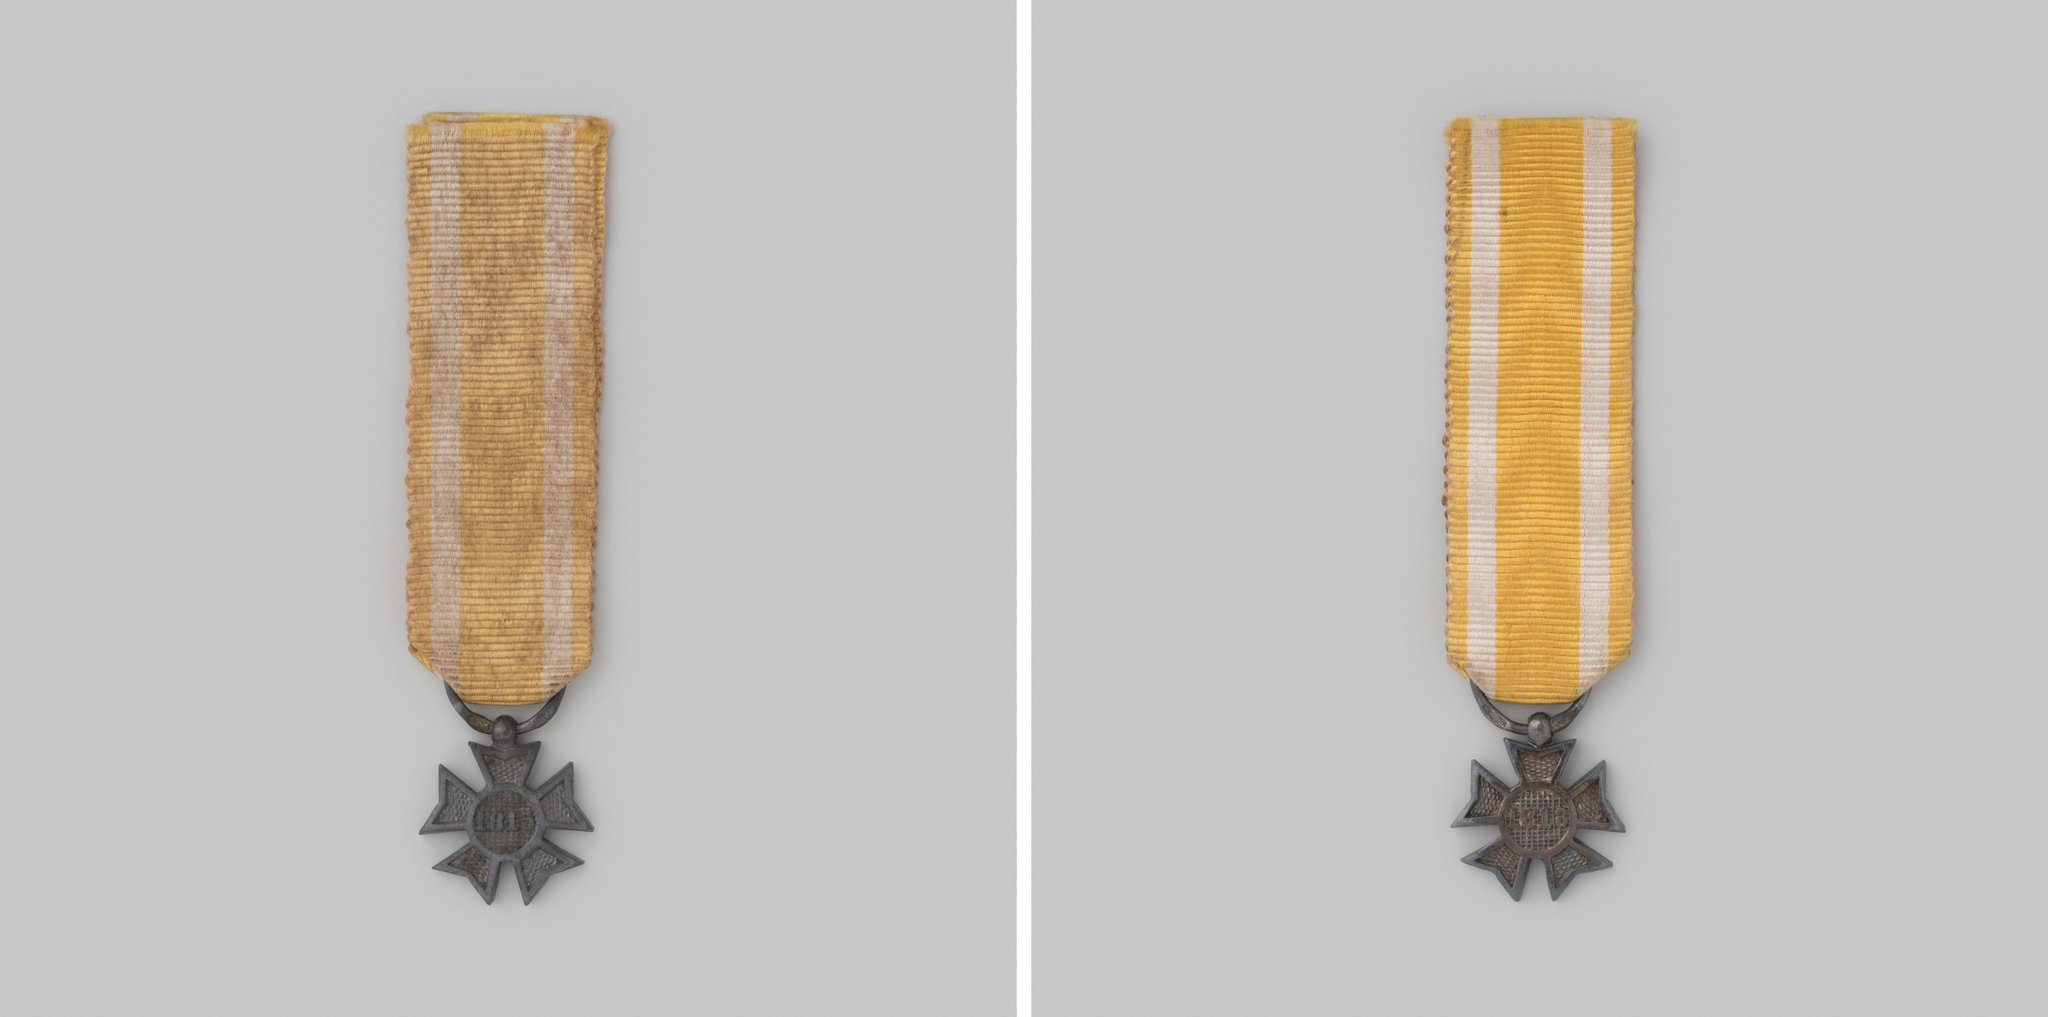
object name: insignia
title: Zilveren kruis, ereteken voor de krijgsverrichtingen in 1813-1815, toegekend aan R.J. Solkamans, korporaal van de Nationale garde tijdens het beleg van Naarden in 1813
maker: Anonymous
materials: silver, textile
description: Zilveren draagpenning met oog, ring en lint, klein model.